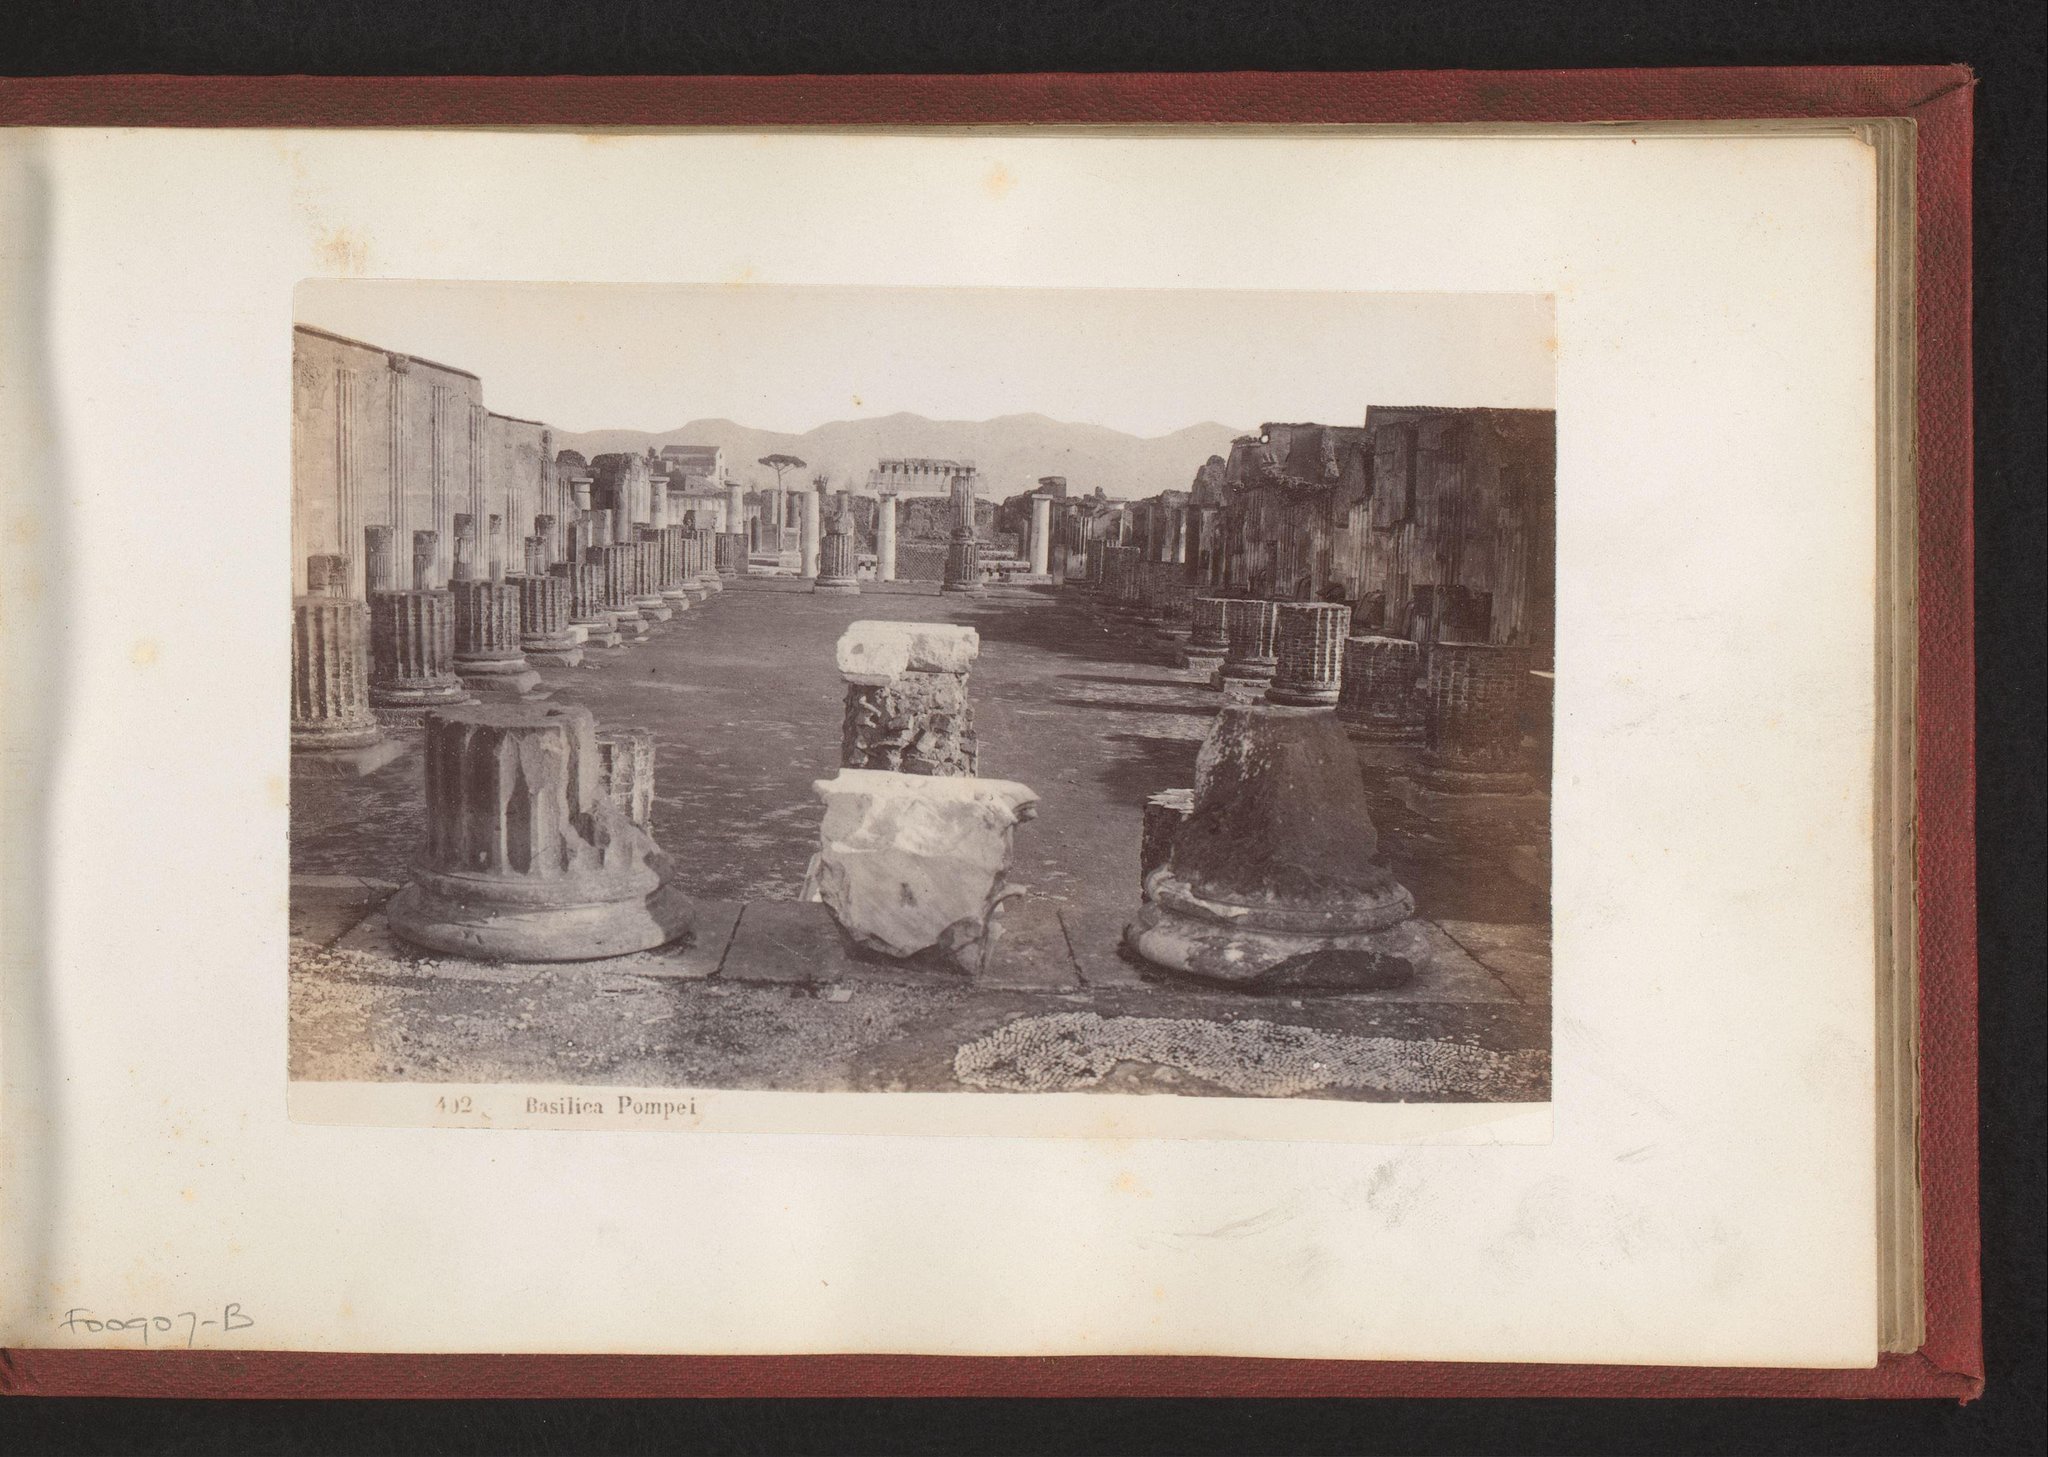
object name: album leaf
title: Basilica Pompei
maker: Anonymous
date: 1860-1900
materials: photographic support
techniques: albumen print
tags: column, pillar ~ architecture, ruin of a building ~ architecture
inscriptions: number: ‘402’